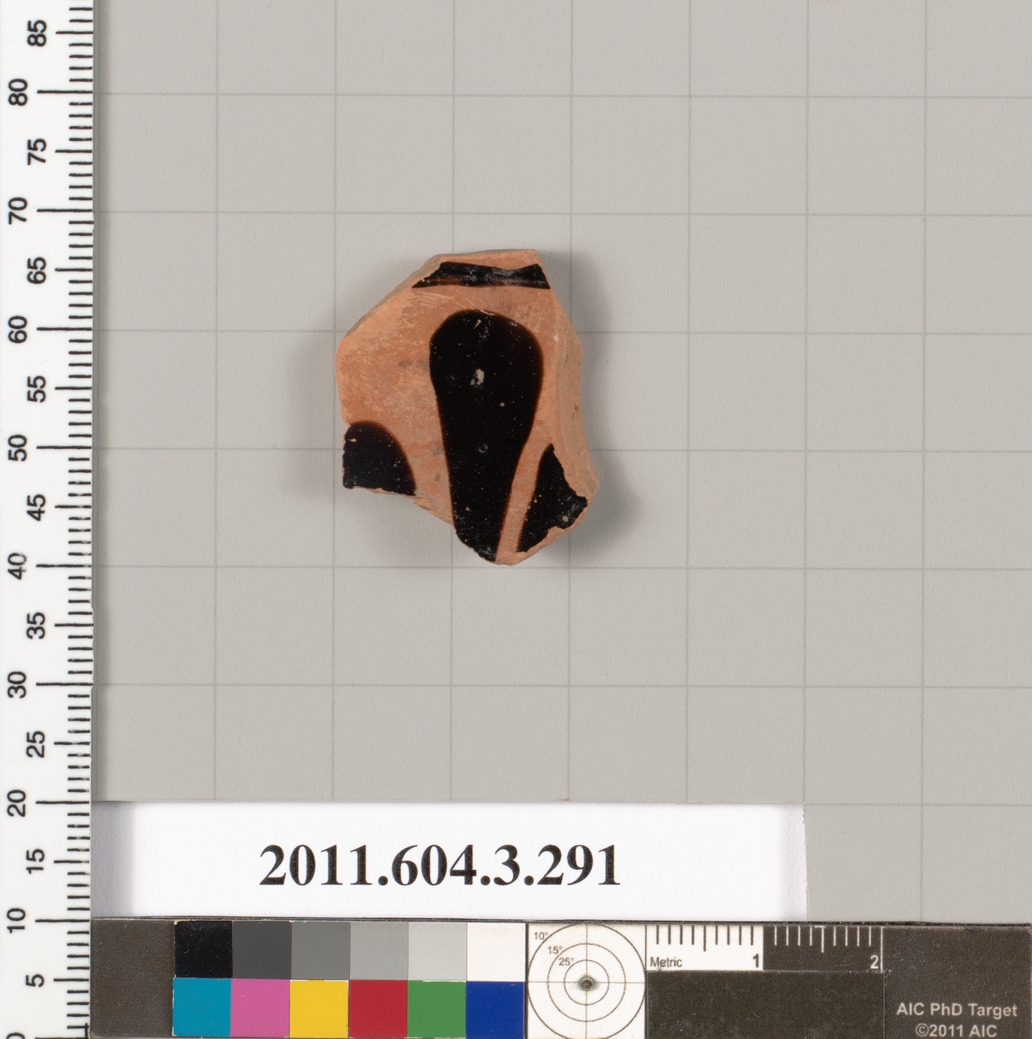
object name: neck amphora fragment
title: Terracotta fragment of a neck-amphora (jar)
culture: greek, attic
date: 534-468 BCE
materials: terracotta